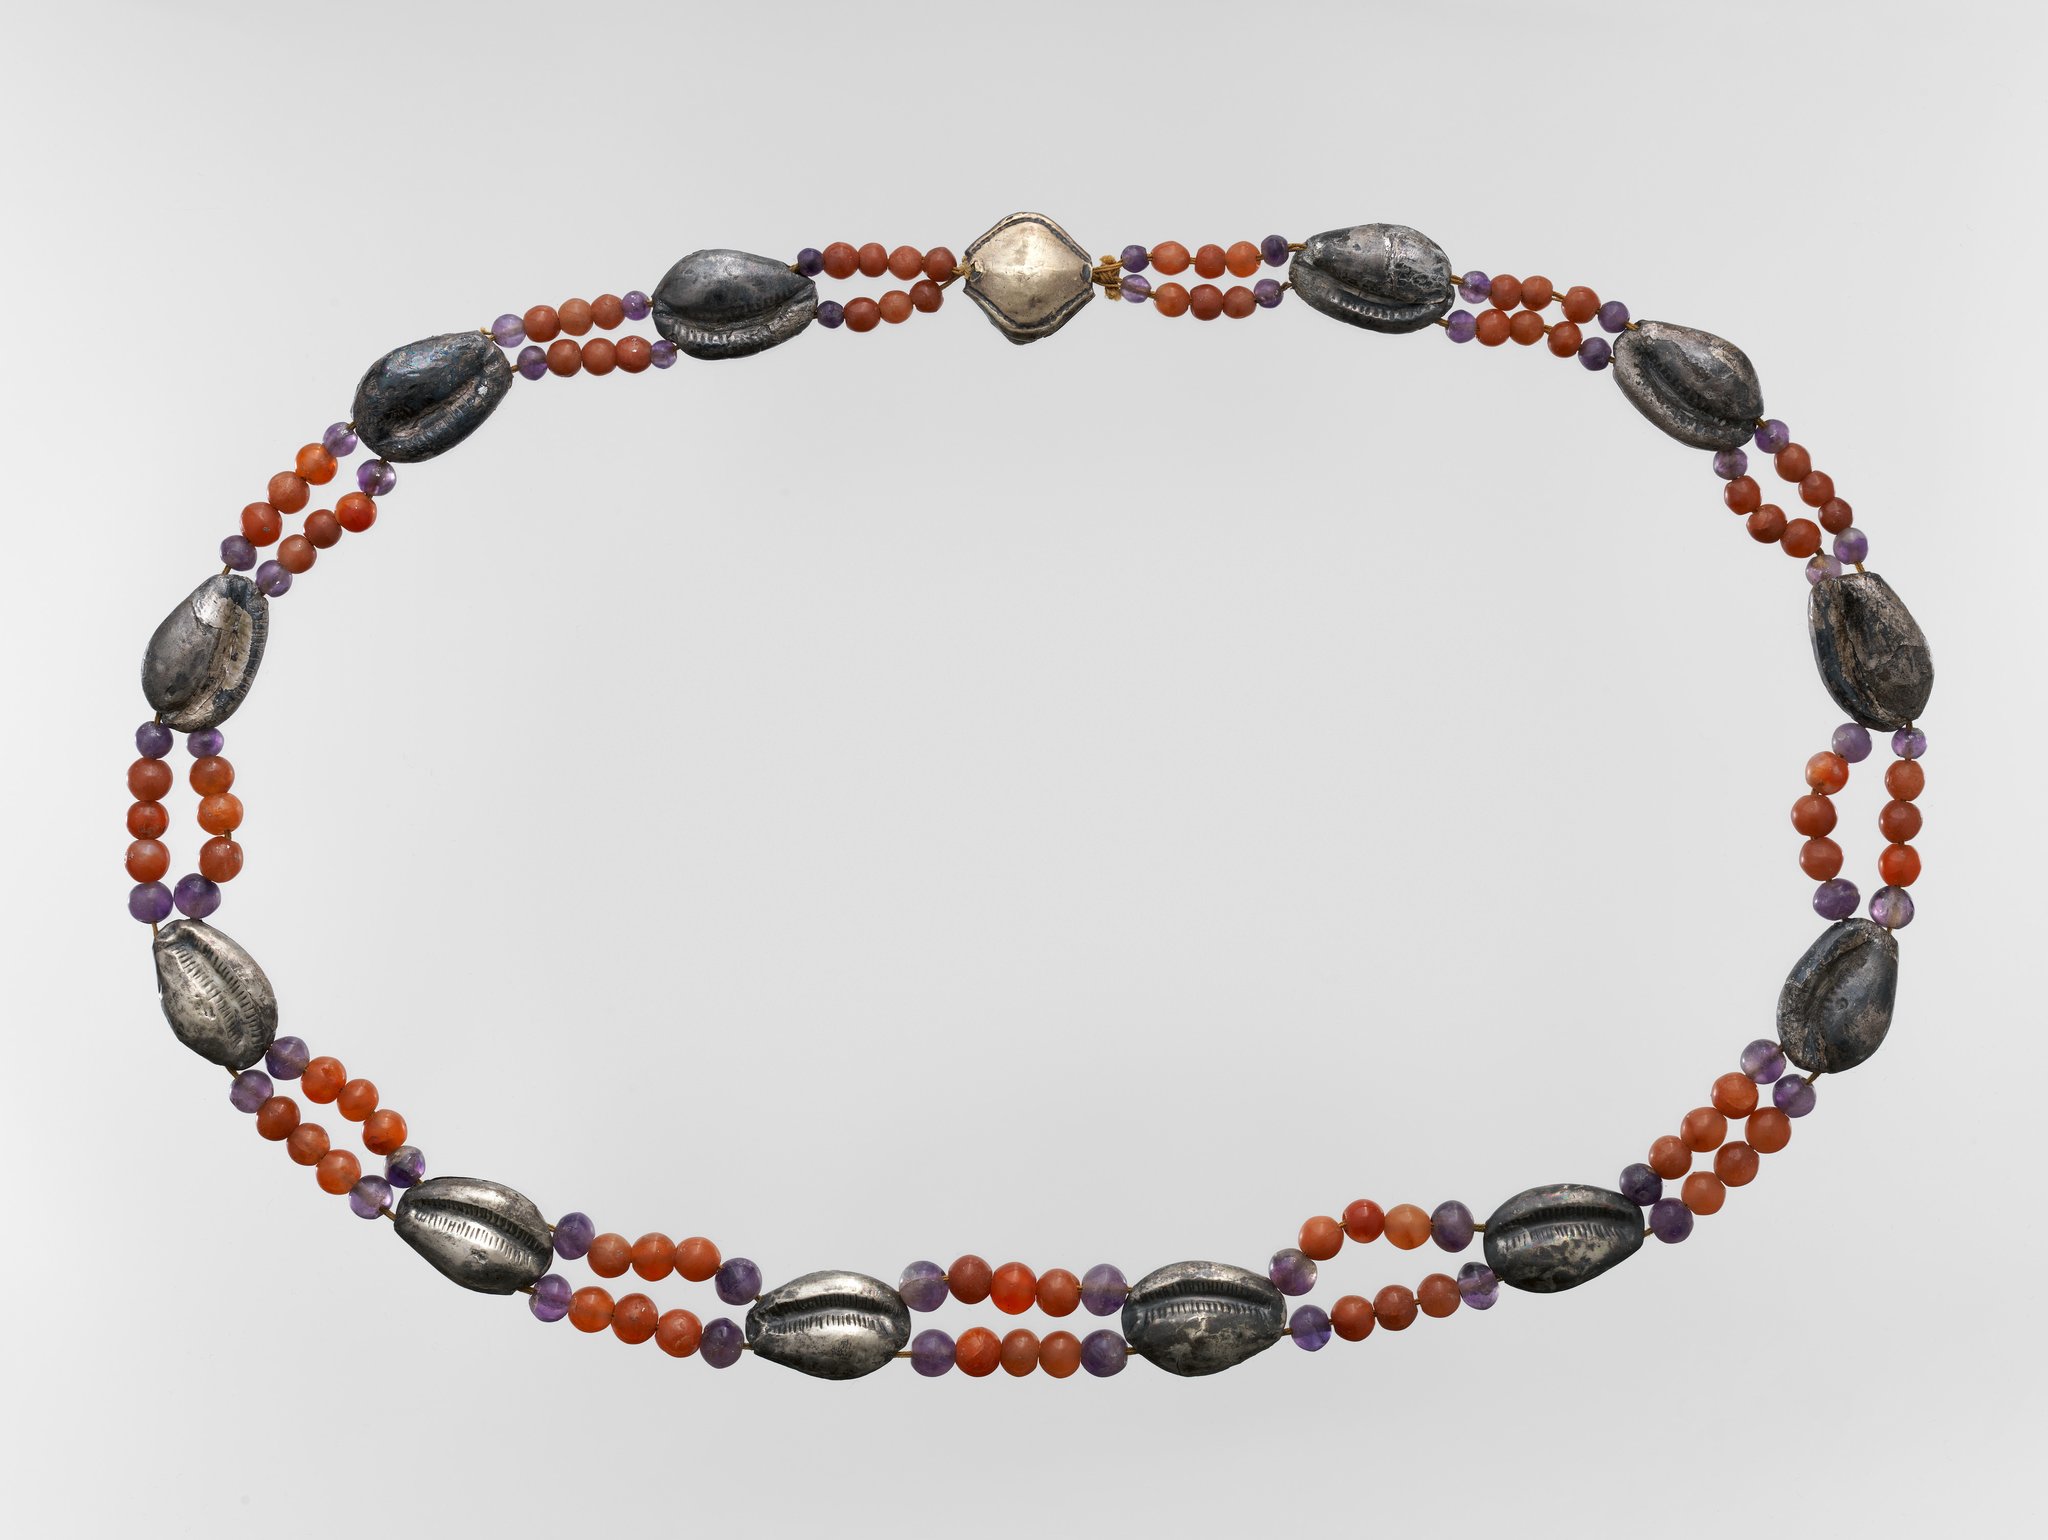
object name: girdle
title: Girdle with Cowrie Shells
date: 1850-1700 BCE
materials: gemstone, plaster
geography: egypt